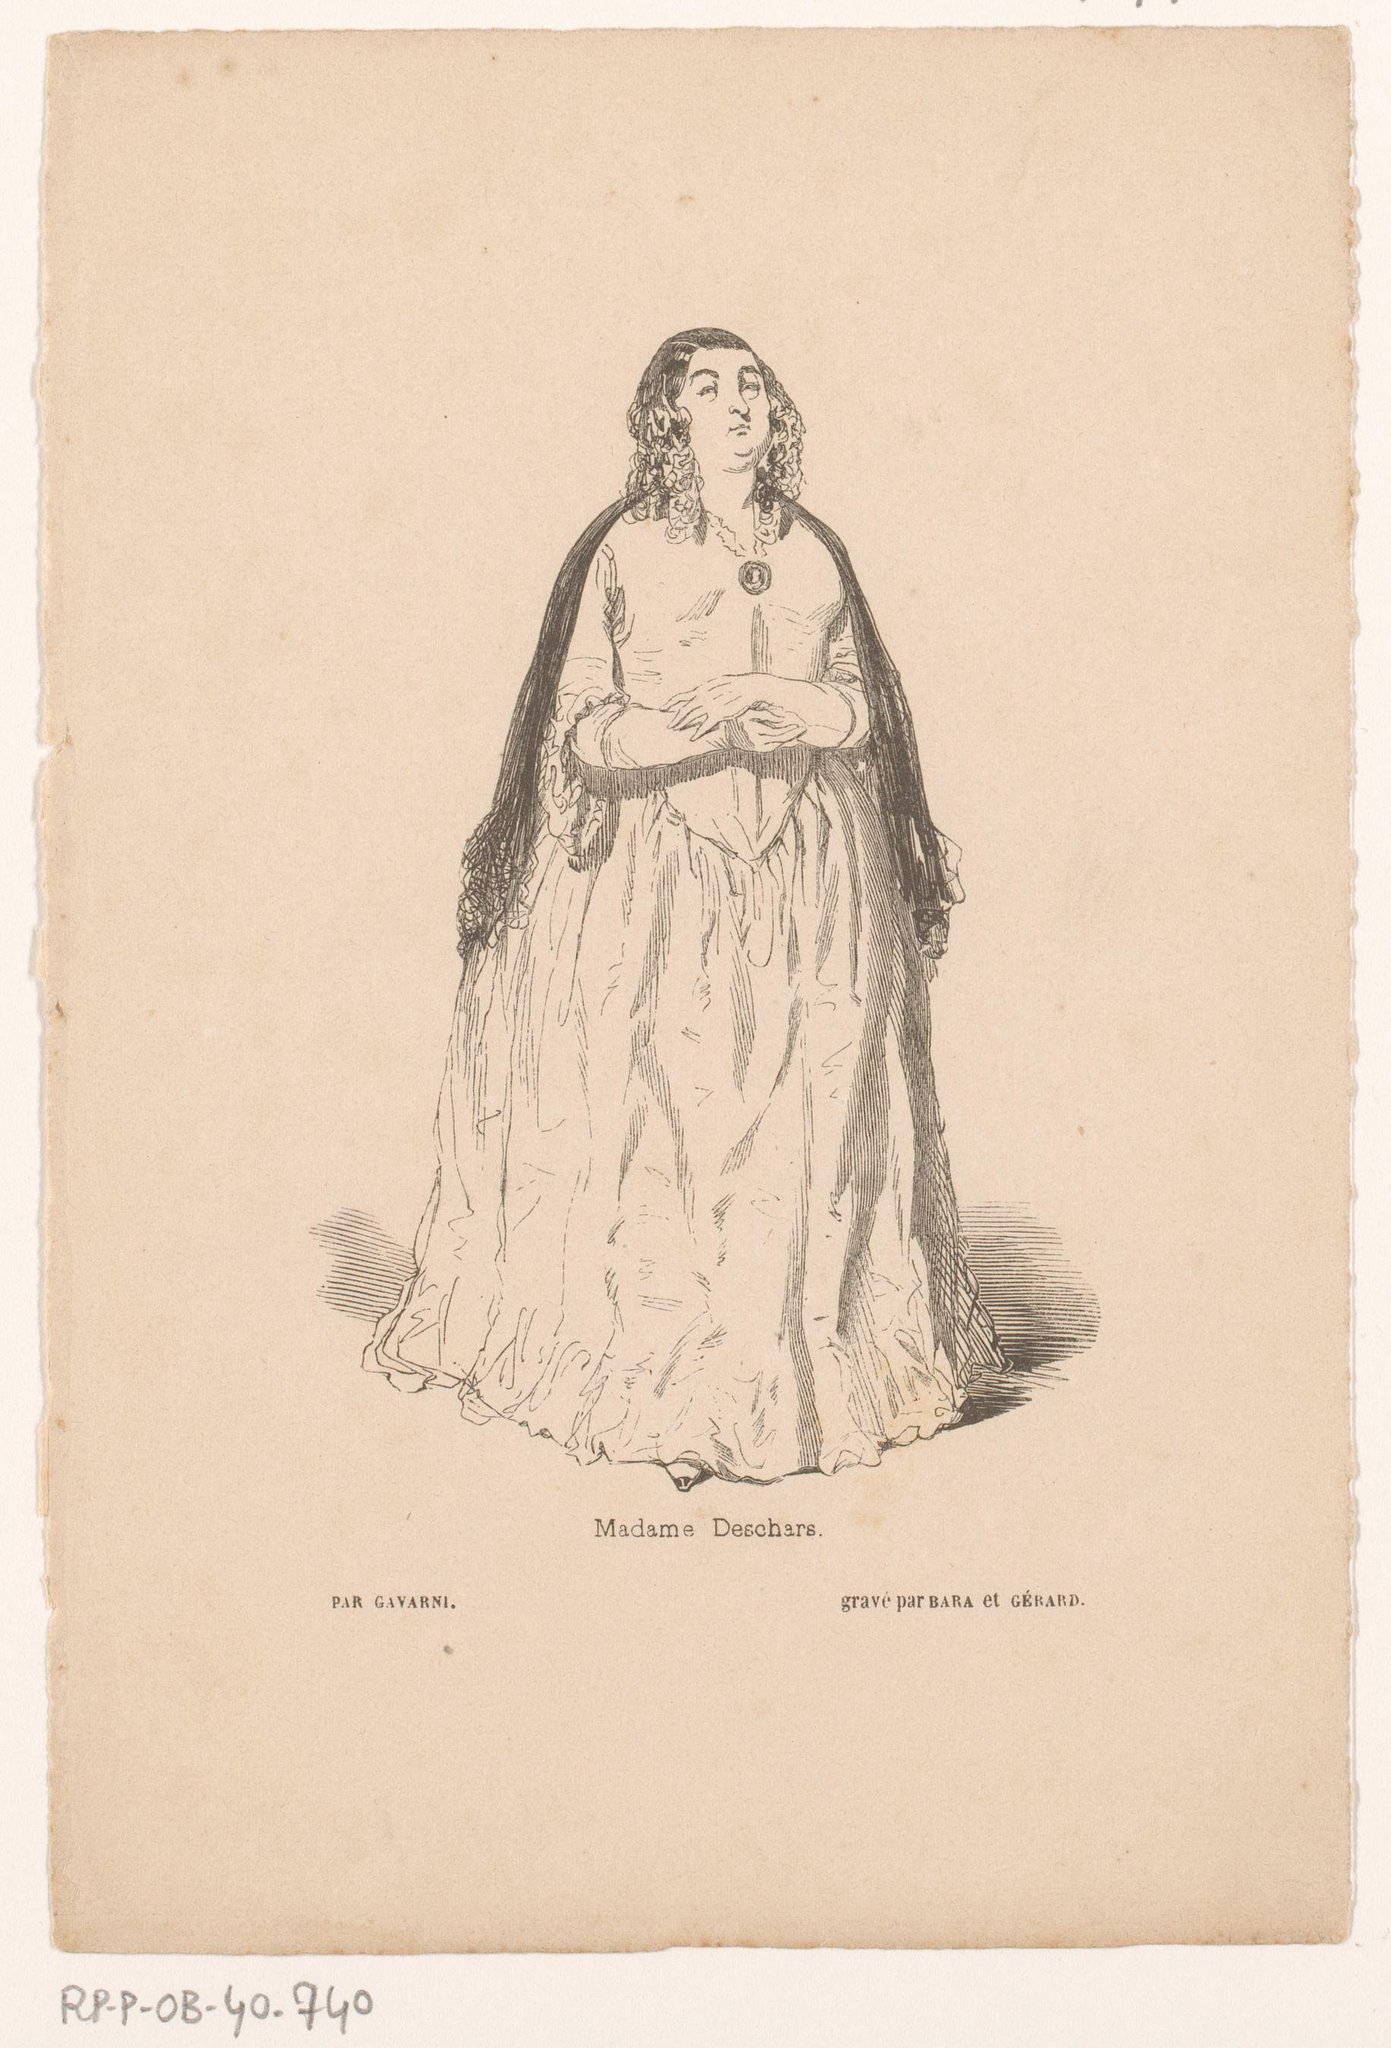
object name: print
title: Les Français peints par eux-mêmes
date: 1840-1842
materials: paper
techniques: lithograph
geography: paris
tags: procuress, standing figure - aa - female human figure, various human types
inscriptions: collector's mark: Lugt 2228a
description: Madame Deschars is een personage van Honoré de Balzac.